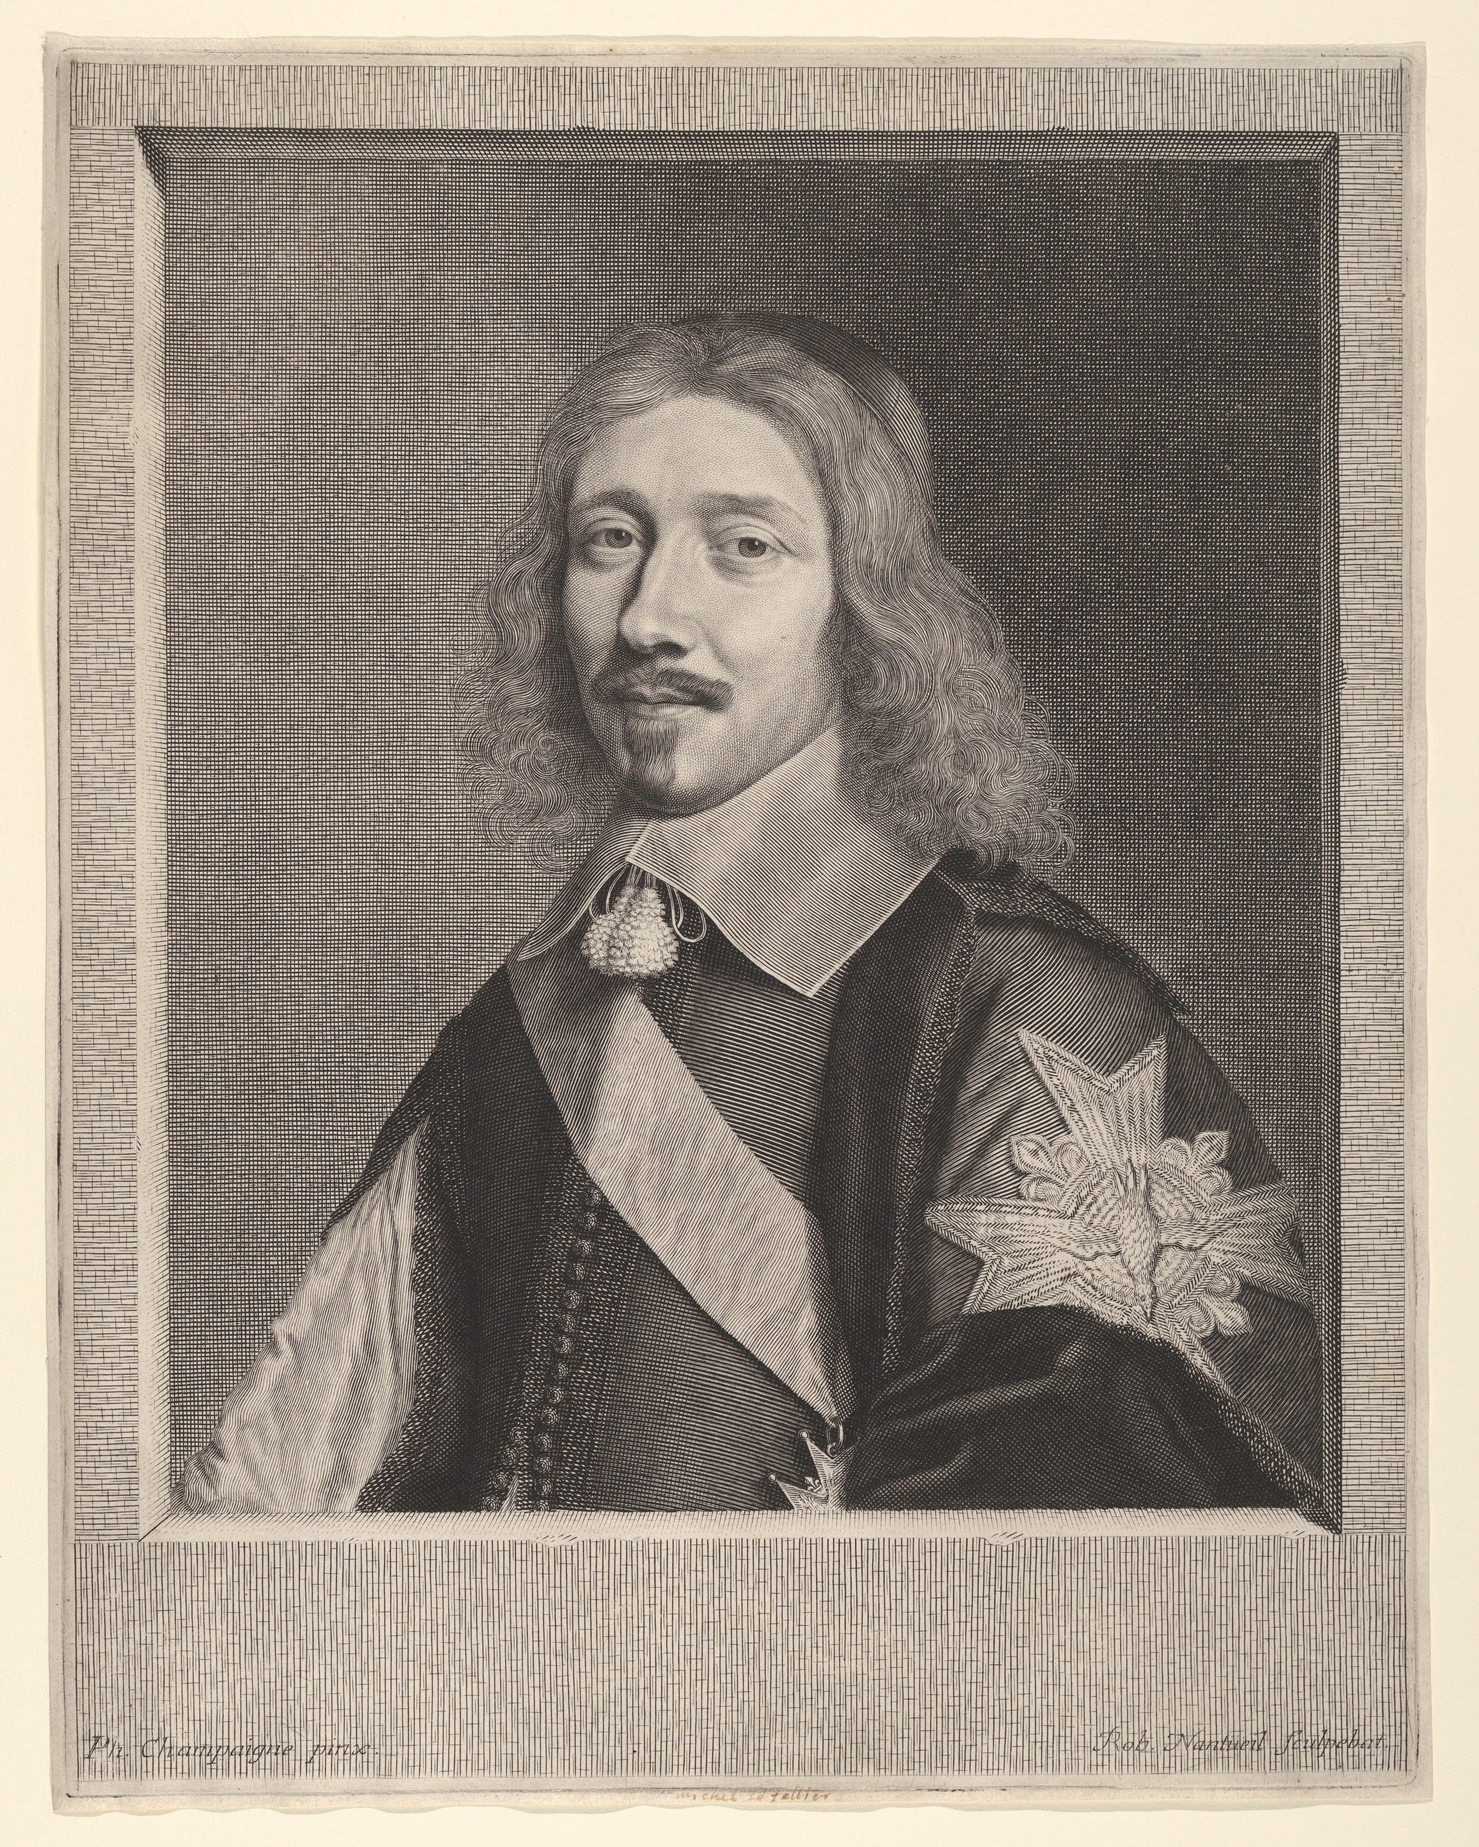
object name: print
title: Michel IV Le Tellier (Le Chancelier)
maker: robert nanteuil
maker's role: artist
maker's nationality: french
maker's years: 1623-1678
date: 1653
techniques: engraving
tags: men,portraits